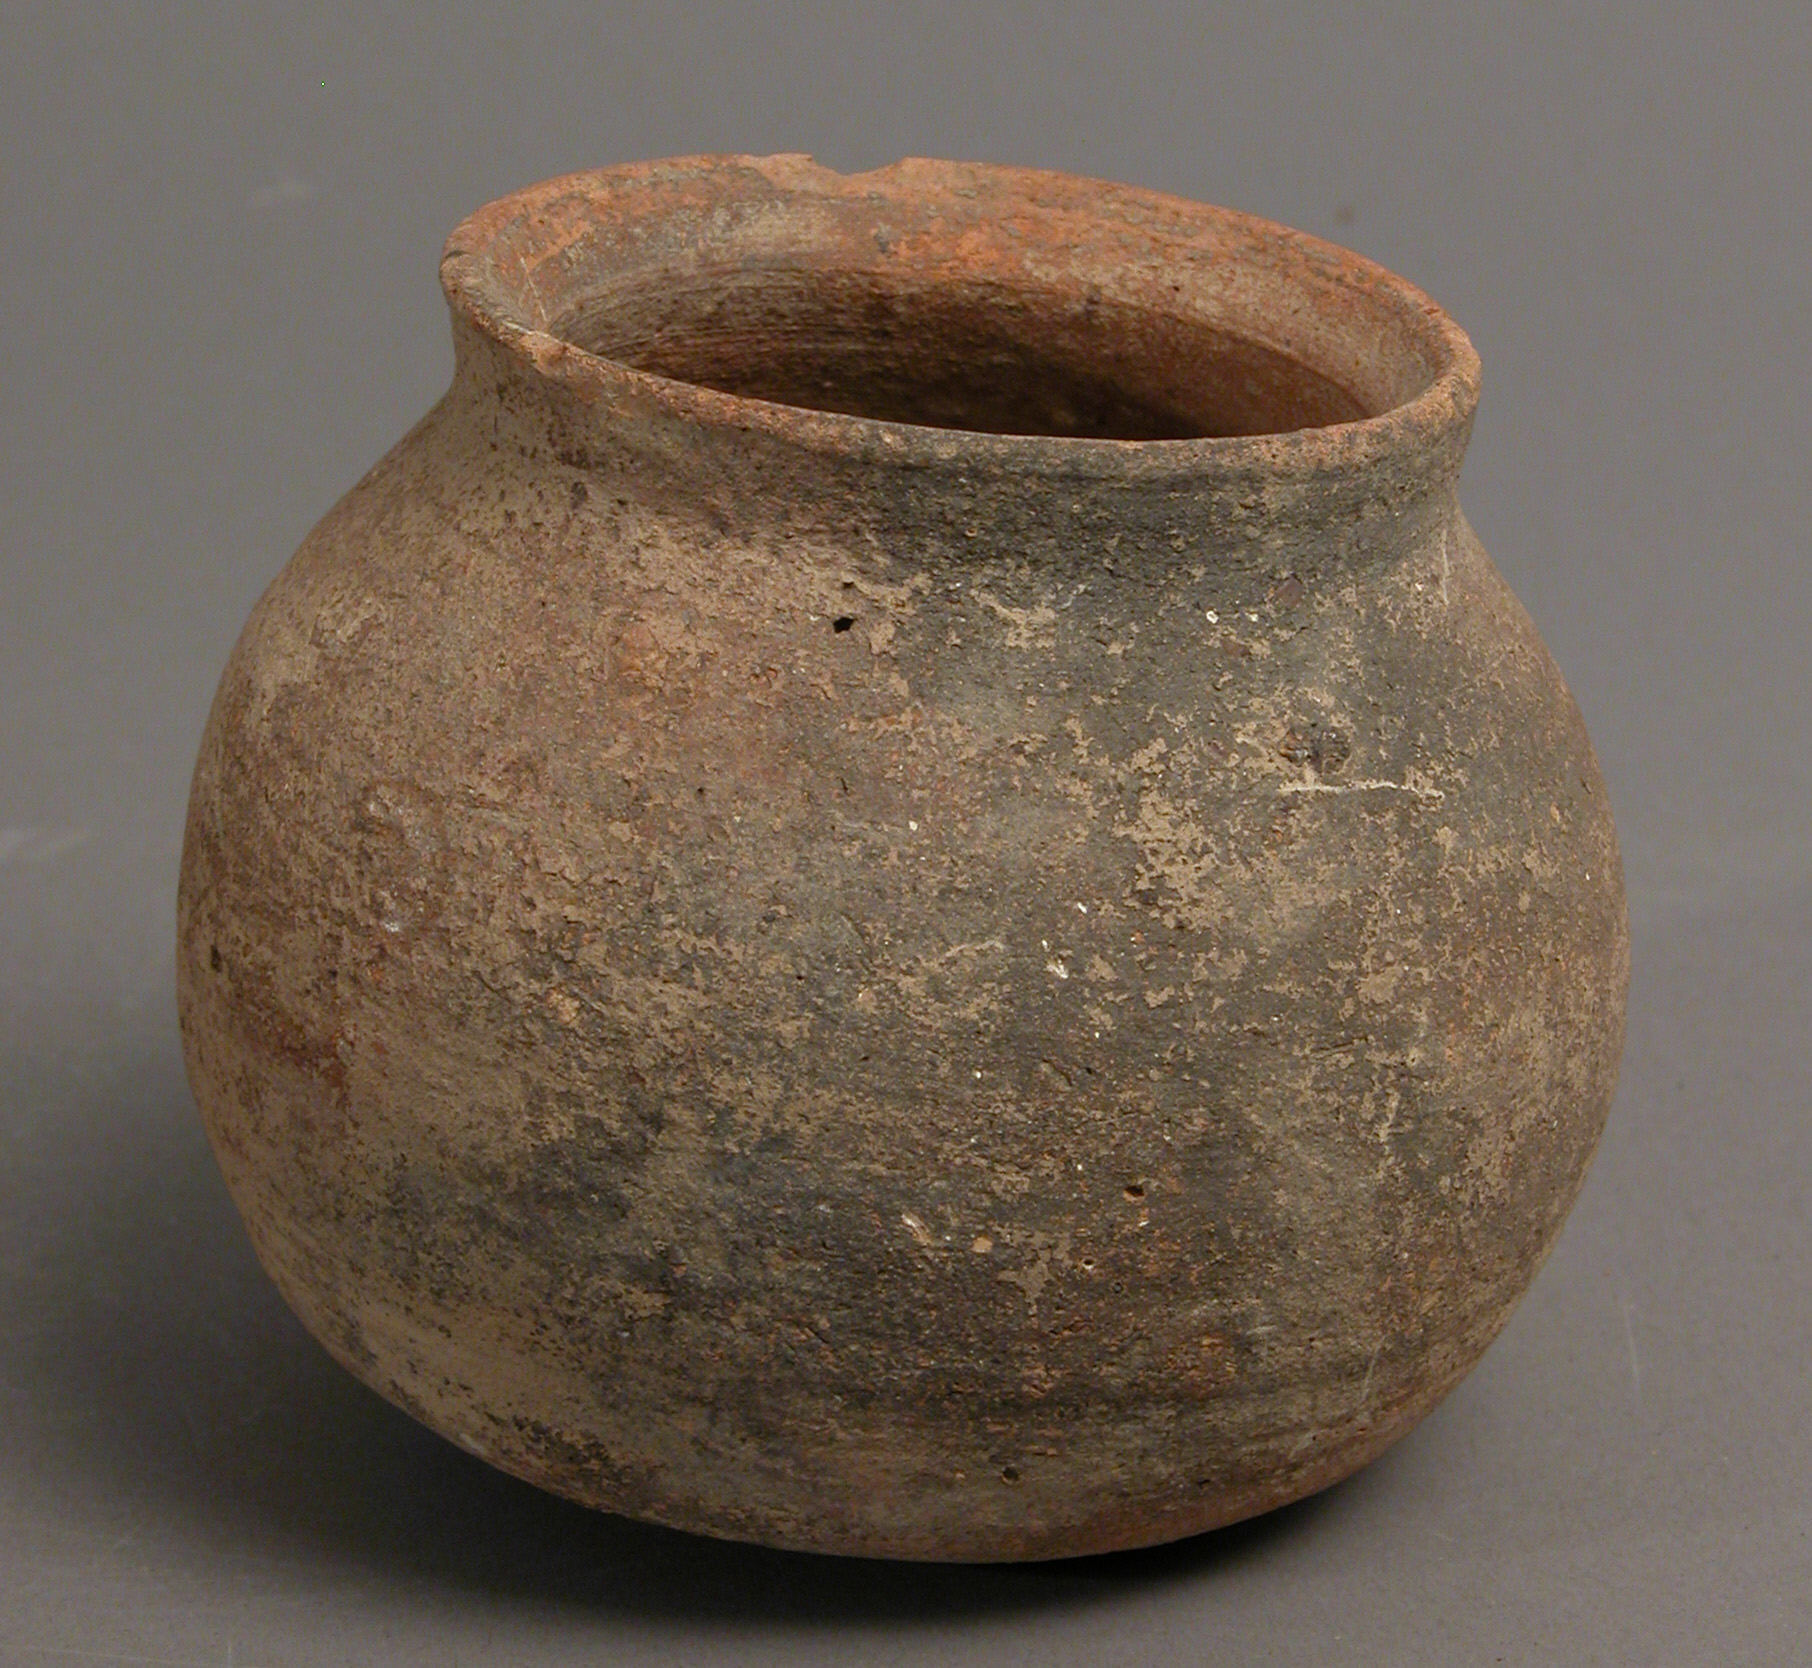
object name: pot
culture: coptic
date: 301-700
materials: earthenware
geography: egypt